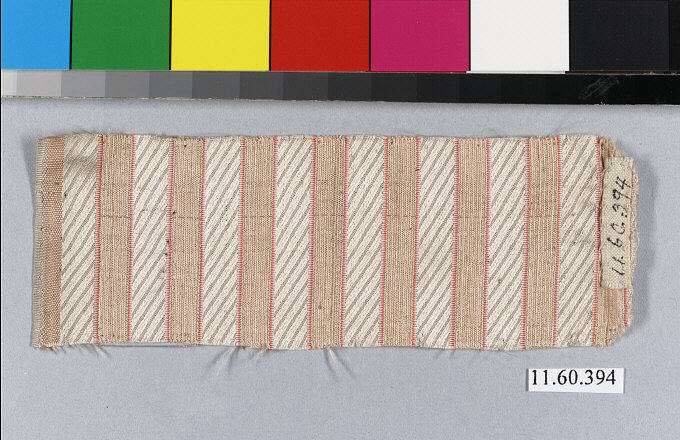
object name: fragment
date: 1801-1900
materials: silk